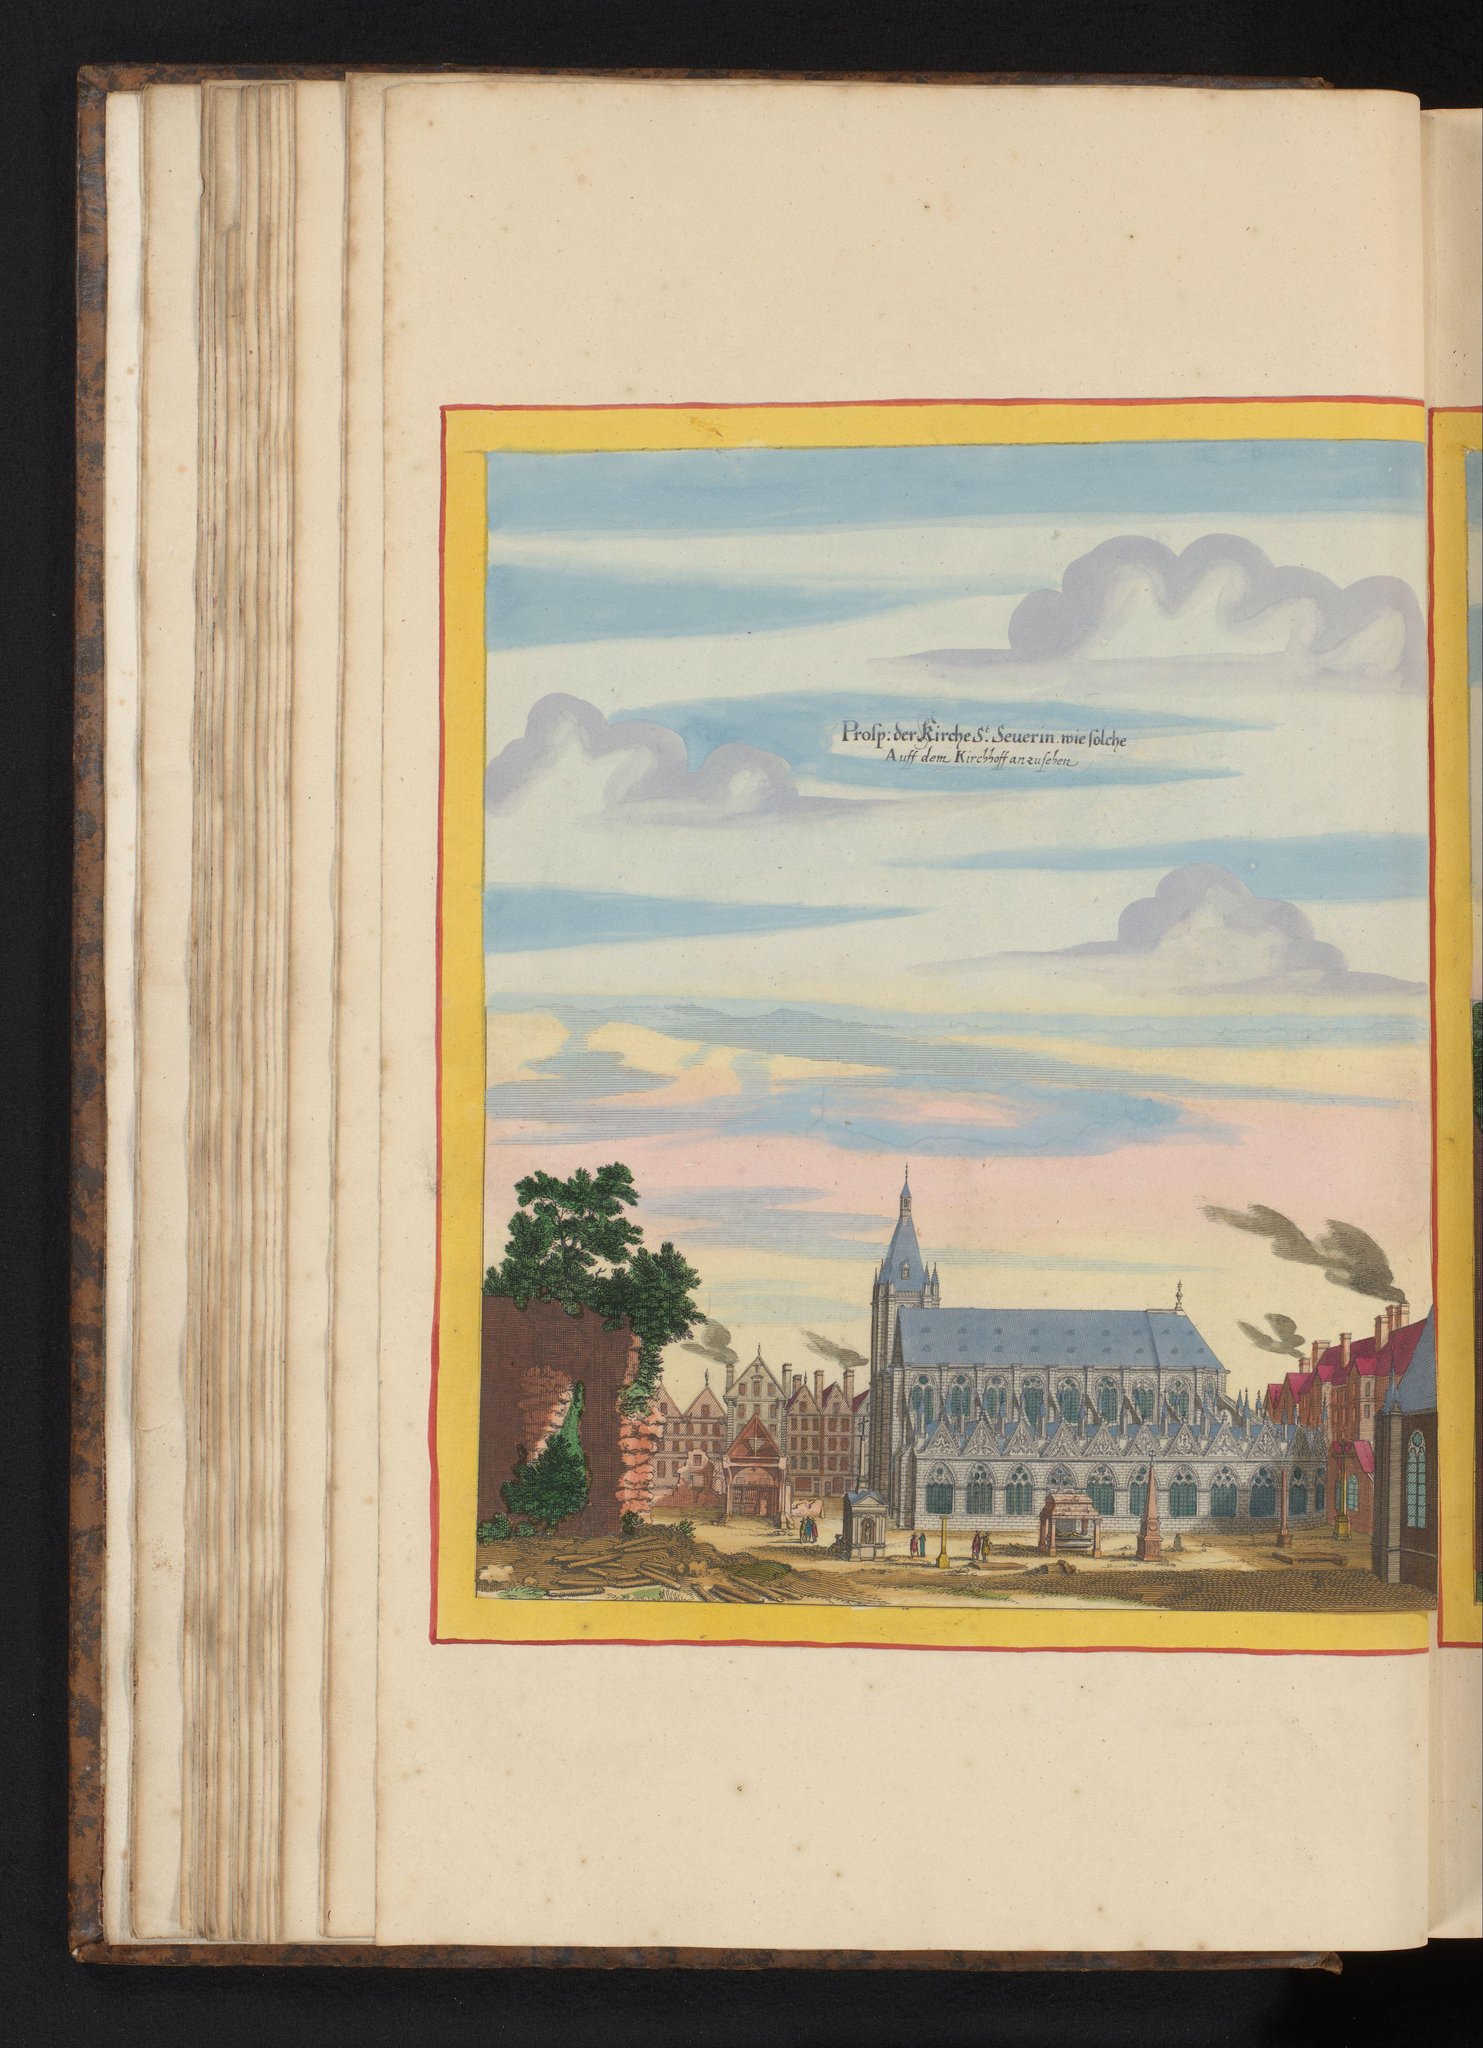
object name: print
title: Gezicht op de kerk van Saint-Séverin te Parijs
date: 1655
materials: paper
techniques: engraving, etching, hand coloring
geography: the hague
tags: church (exterior)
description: Prent origineel vervaardigd als boekillustratie voor: Zeiller, Martin. Topographia Galliae, oder Beschreibung und Contrafaitung der vornehmbsten und bekantisten Oerter in dem mächtigen und grossen Königreich Frankreich, 13 delen. Frankfurt am Main: Caspar Merian, 1655-1661. De prent werd voor het eerst gepubliceerd in deel 1: Topographia Galliae, 1655.